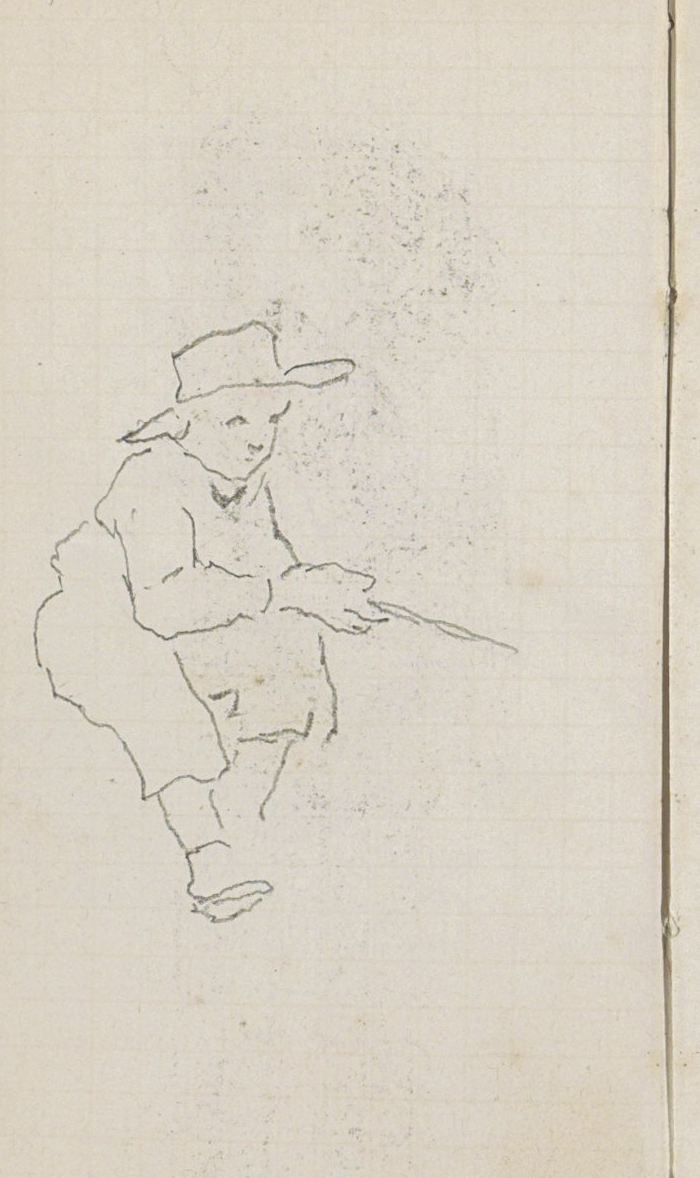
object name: sketchbook leaf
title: Zittende jongen met hengel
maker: jan willem van borselen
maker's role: draughtsman, print maker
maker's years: 1825-1892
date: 1868-1887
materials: pencil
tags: trees (+ branch, stick), boy (child between toddler and youth)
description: Blad 9 verso uit een schetsboek met 51 bladen.